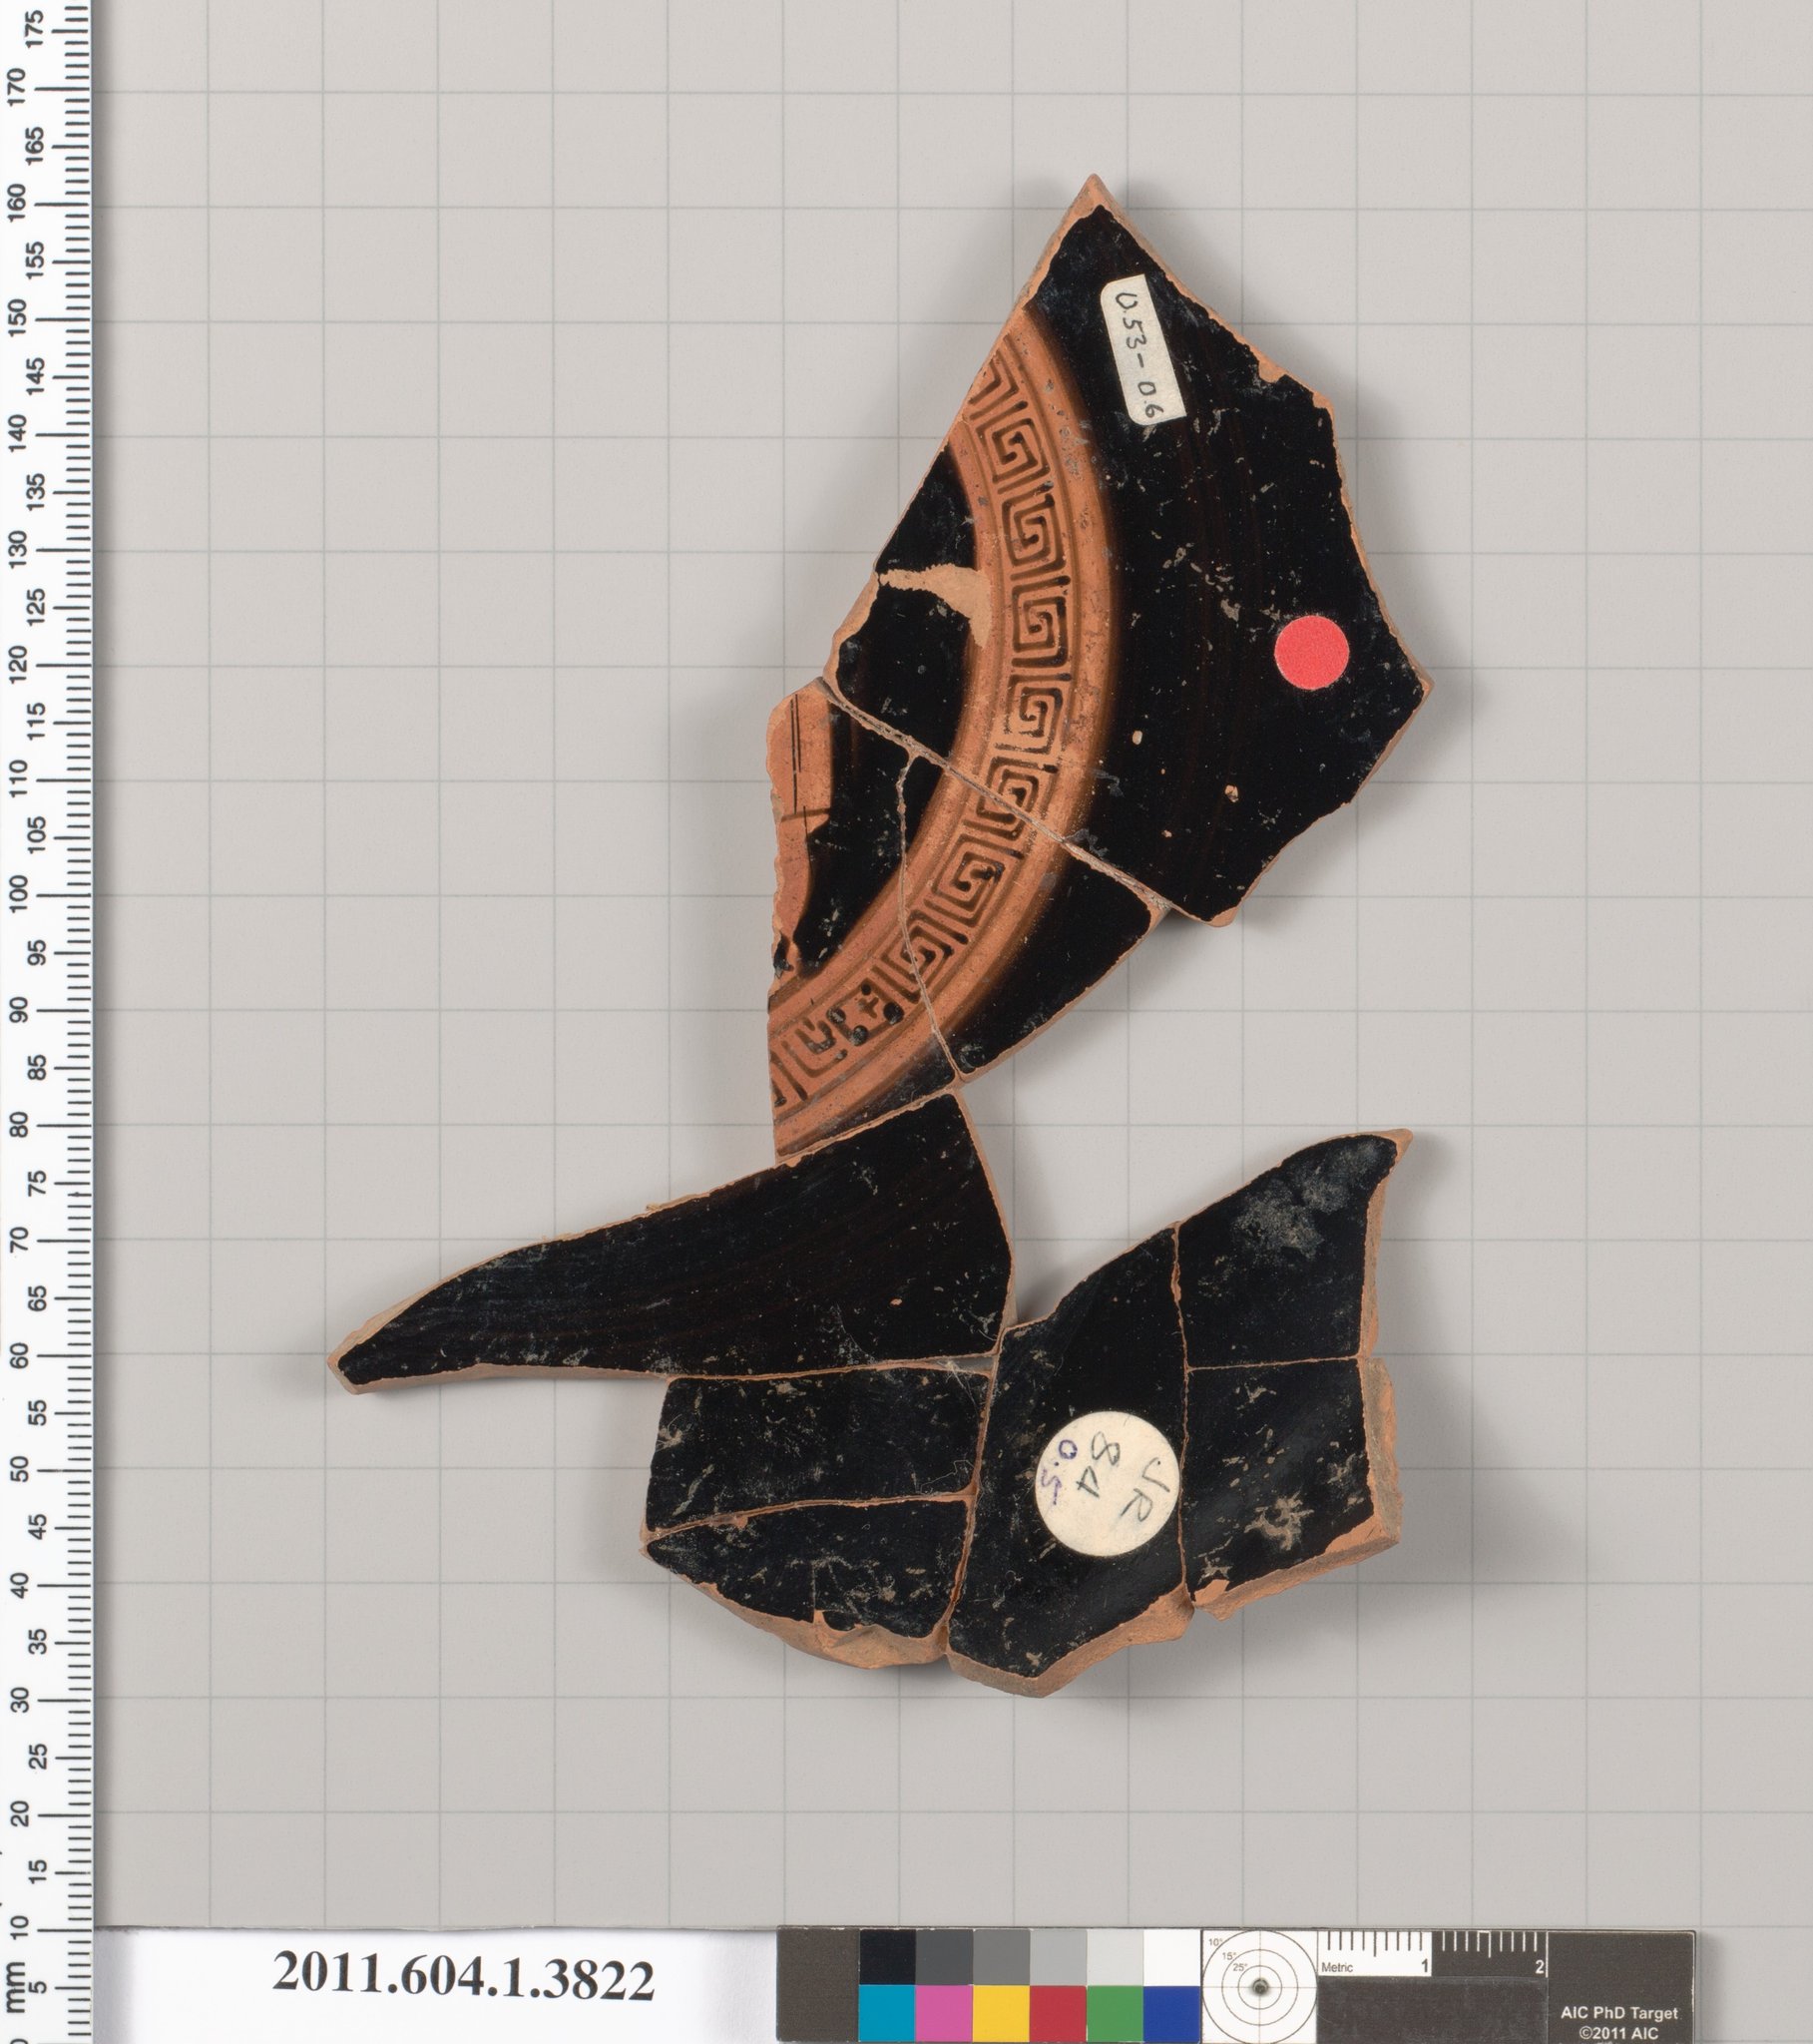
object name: kylix fragment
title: Terracotta fragment of a kylix (drinking cup)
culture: greek, attic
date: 470-450 BCE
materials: terracotta